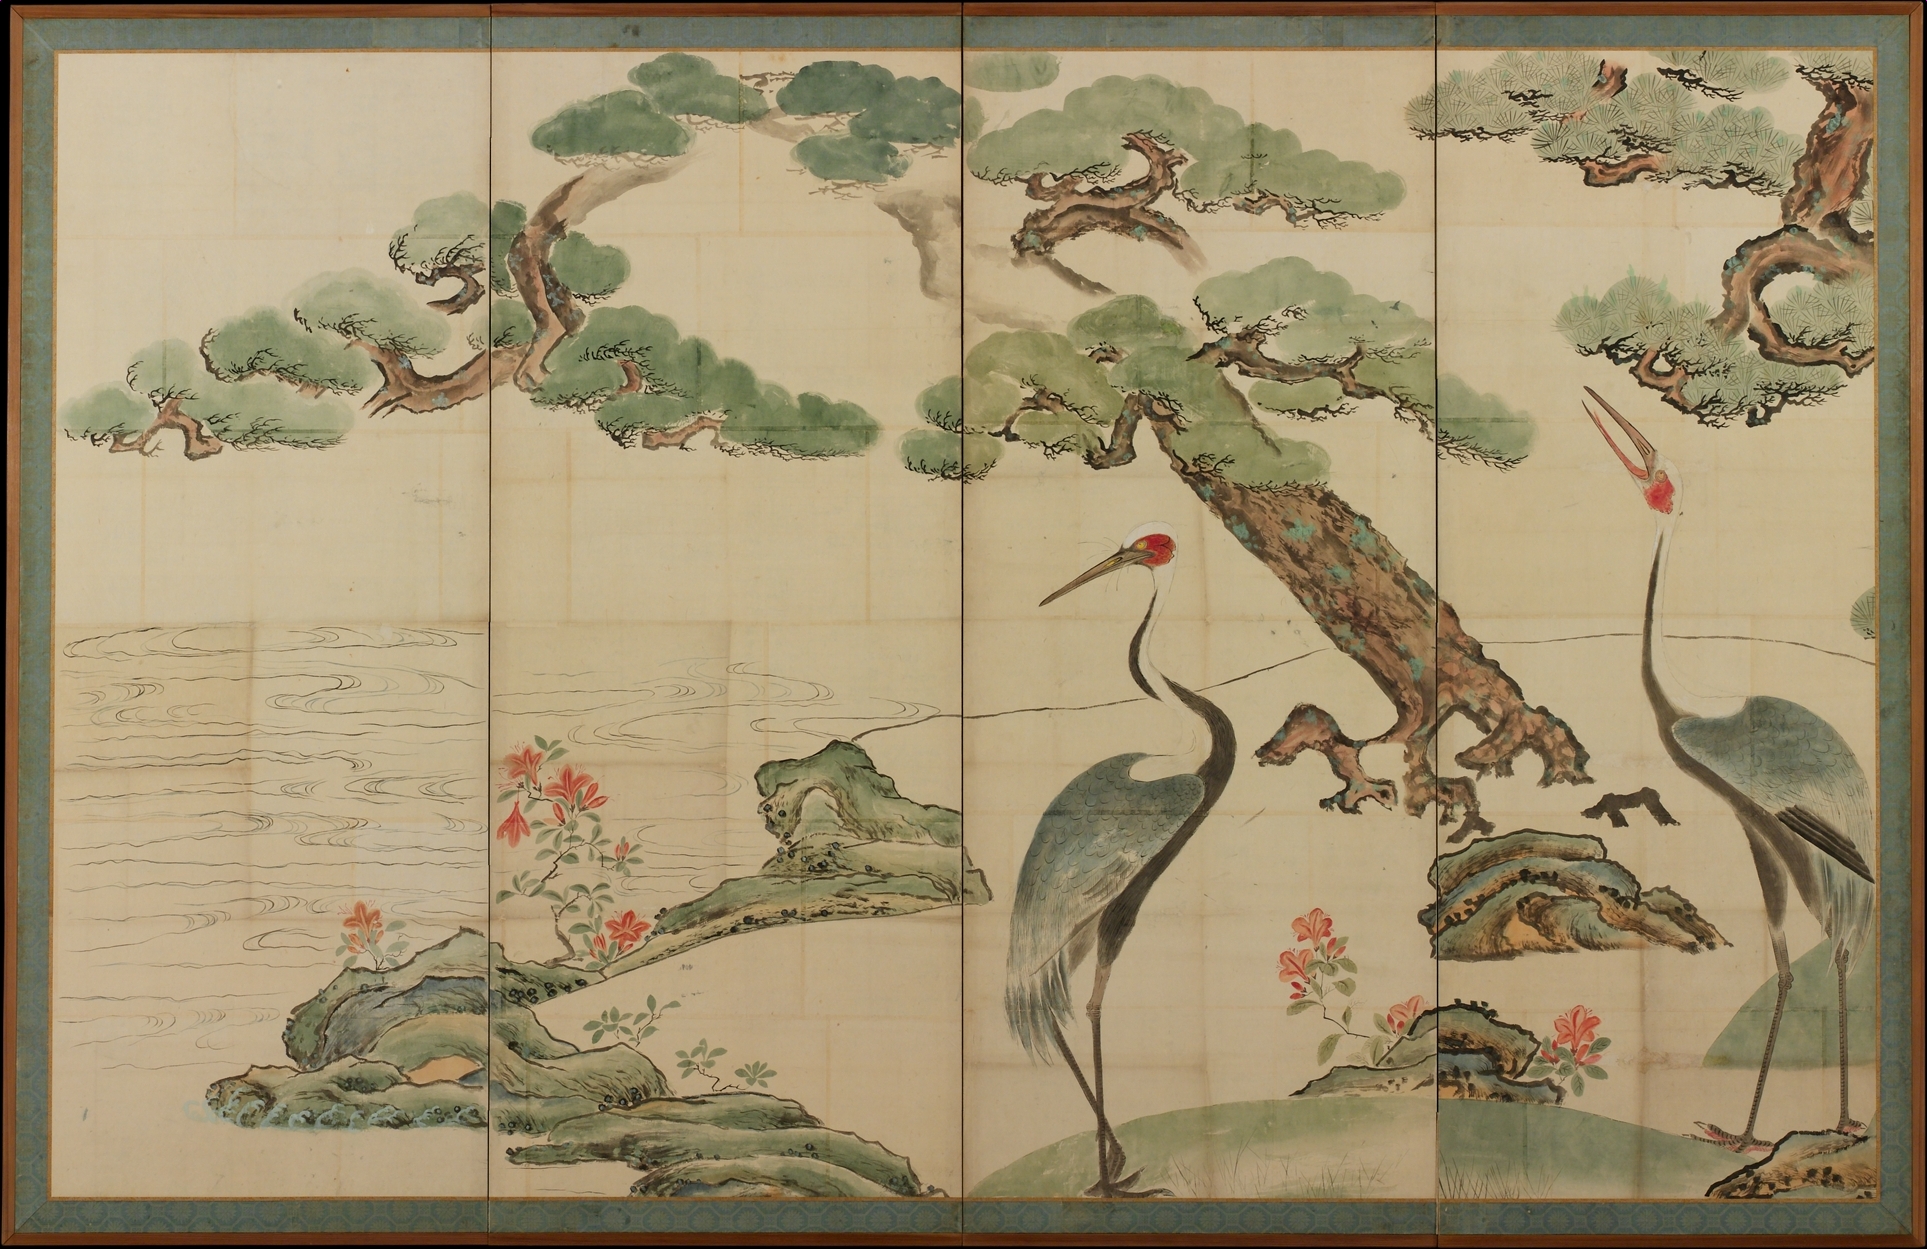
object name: screen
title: Cranes, Pines, and Bamboo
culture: japanese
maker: ogata kōrin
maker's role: artist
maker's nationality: japanese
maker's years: 1658-1716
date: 1701-1733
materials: ink, paper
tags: cranes,bamboo,trees